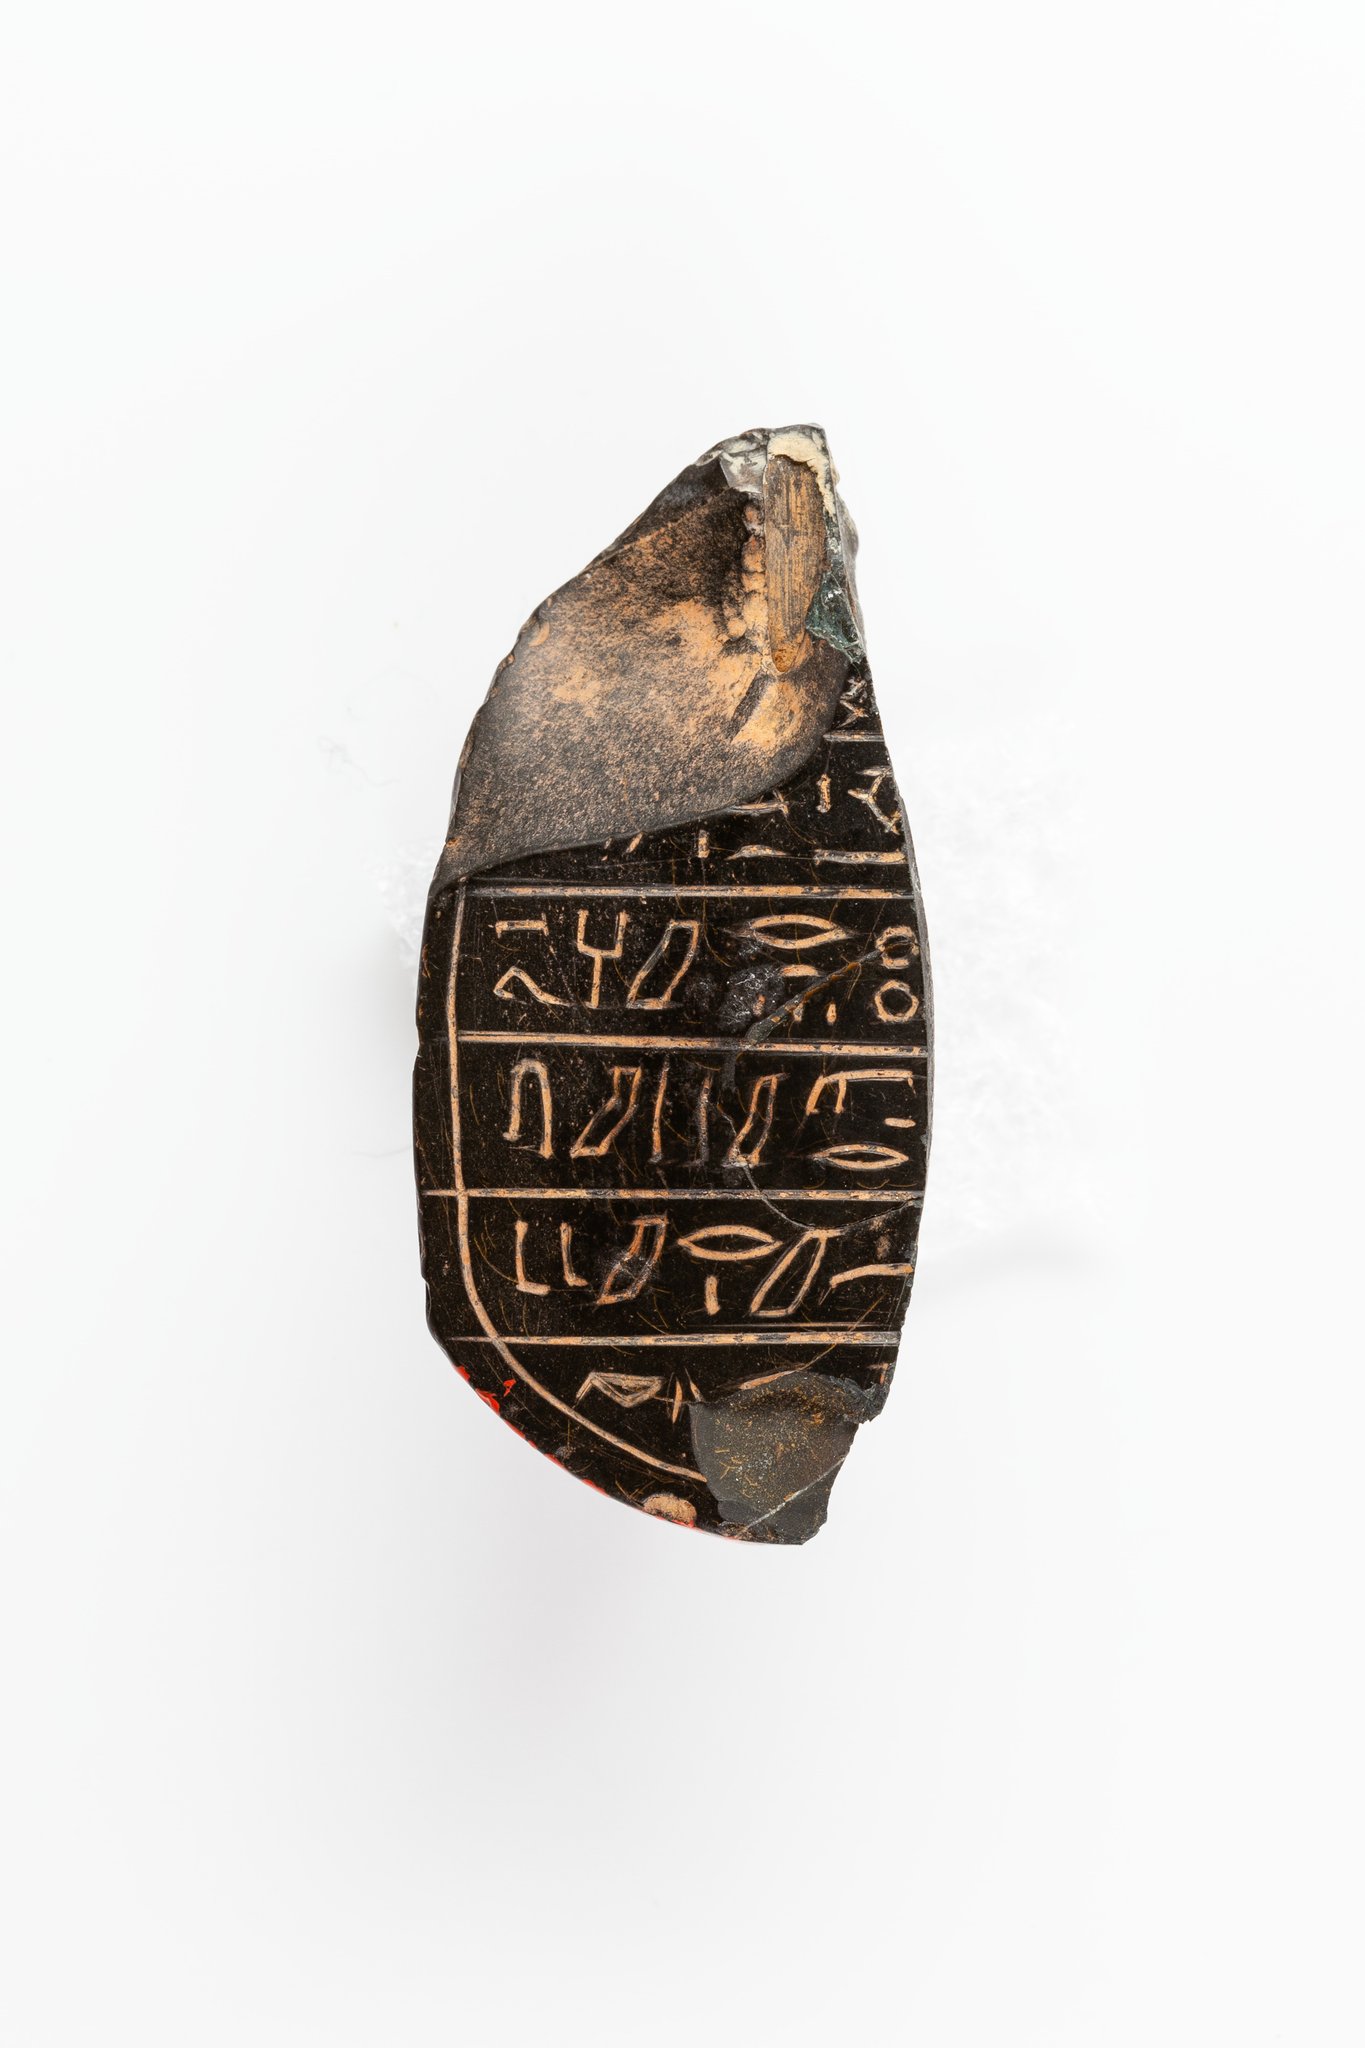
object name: heart scarab, human face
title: Fragment of a Human-Headed Heart Scarab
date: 1802-1550 BCE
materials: stone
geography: egypt